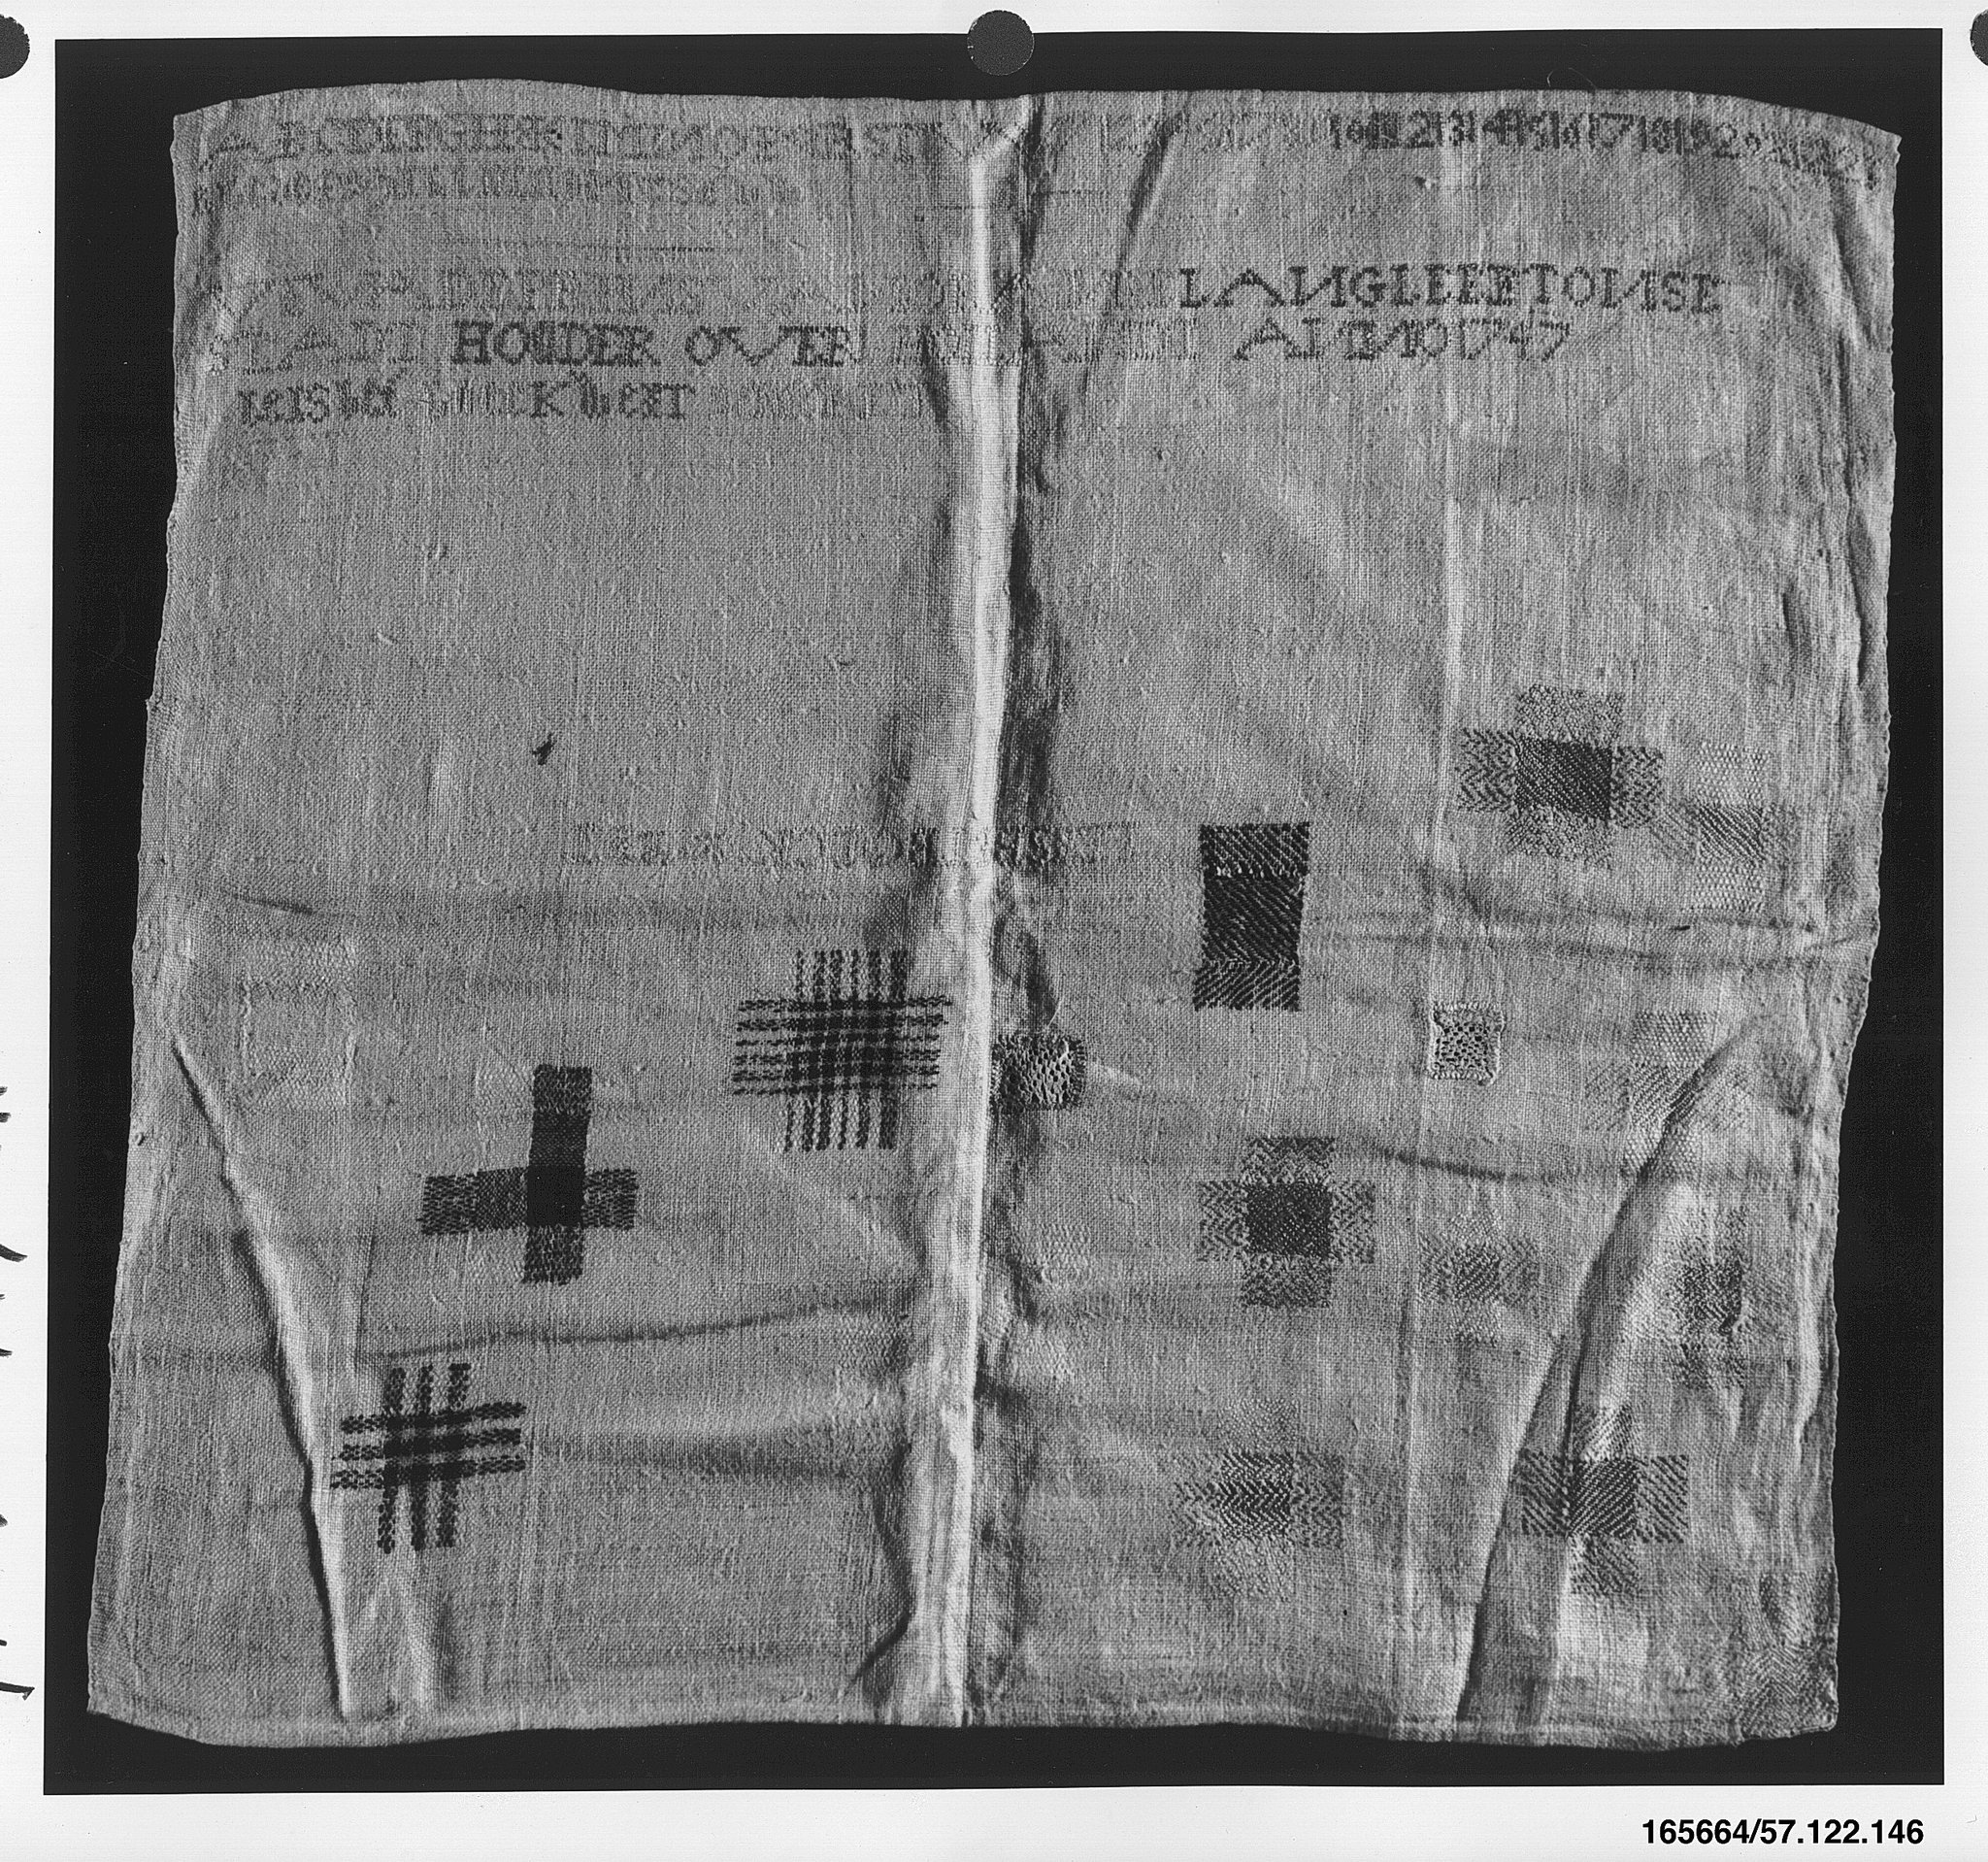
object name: sampler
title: Embroidered darning sampler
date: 1747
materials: cotton, linen, silk